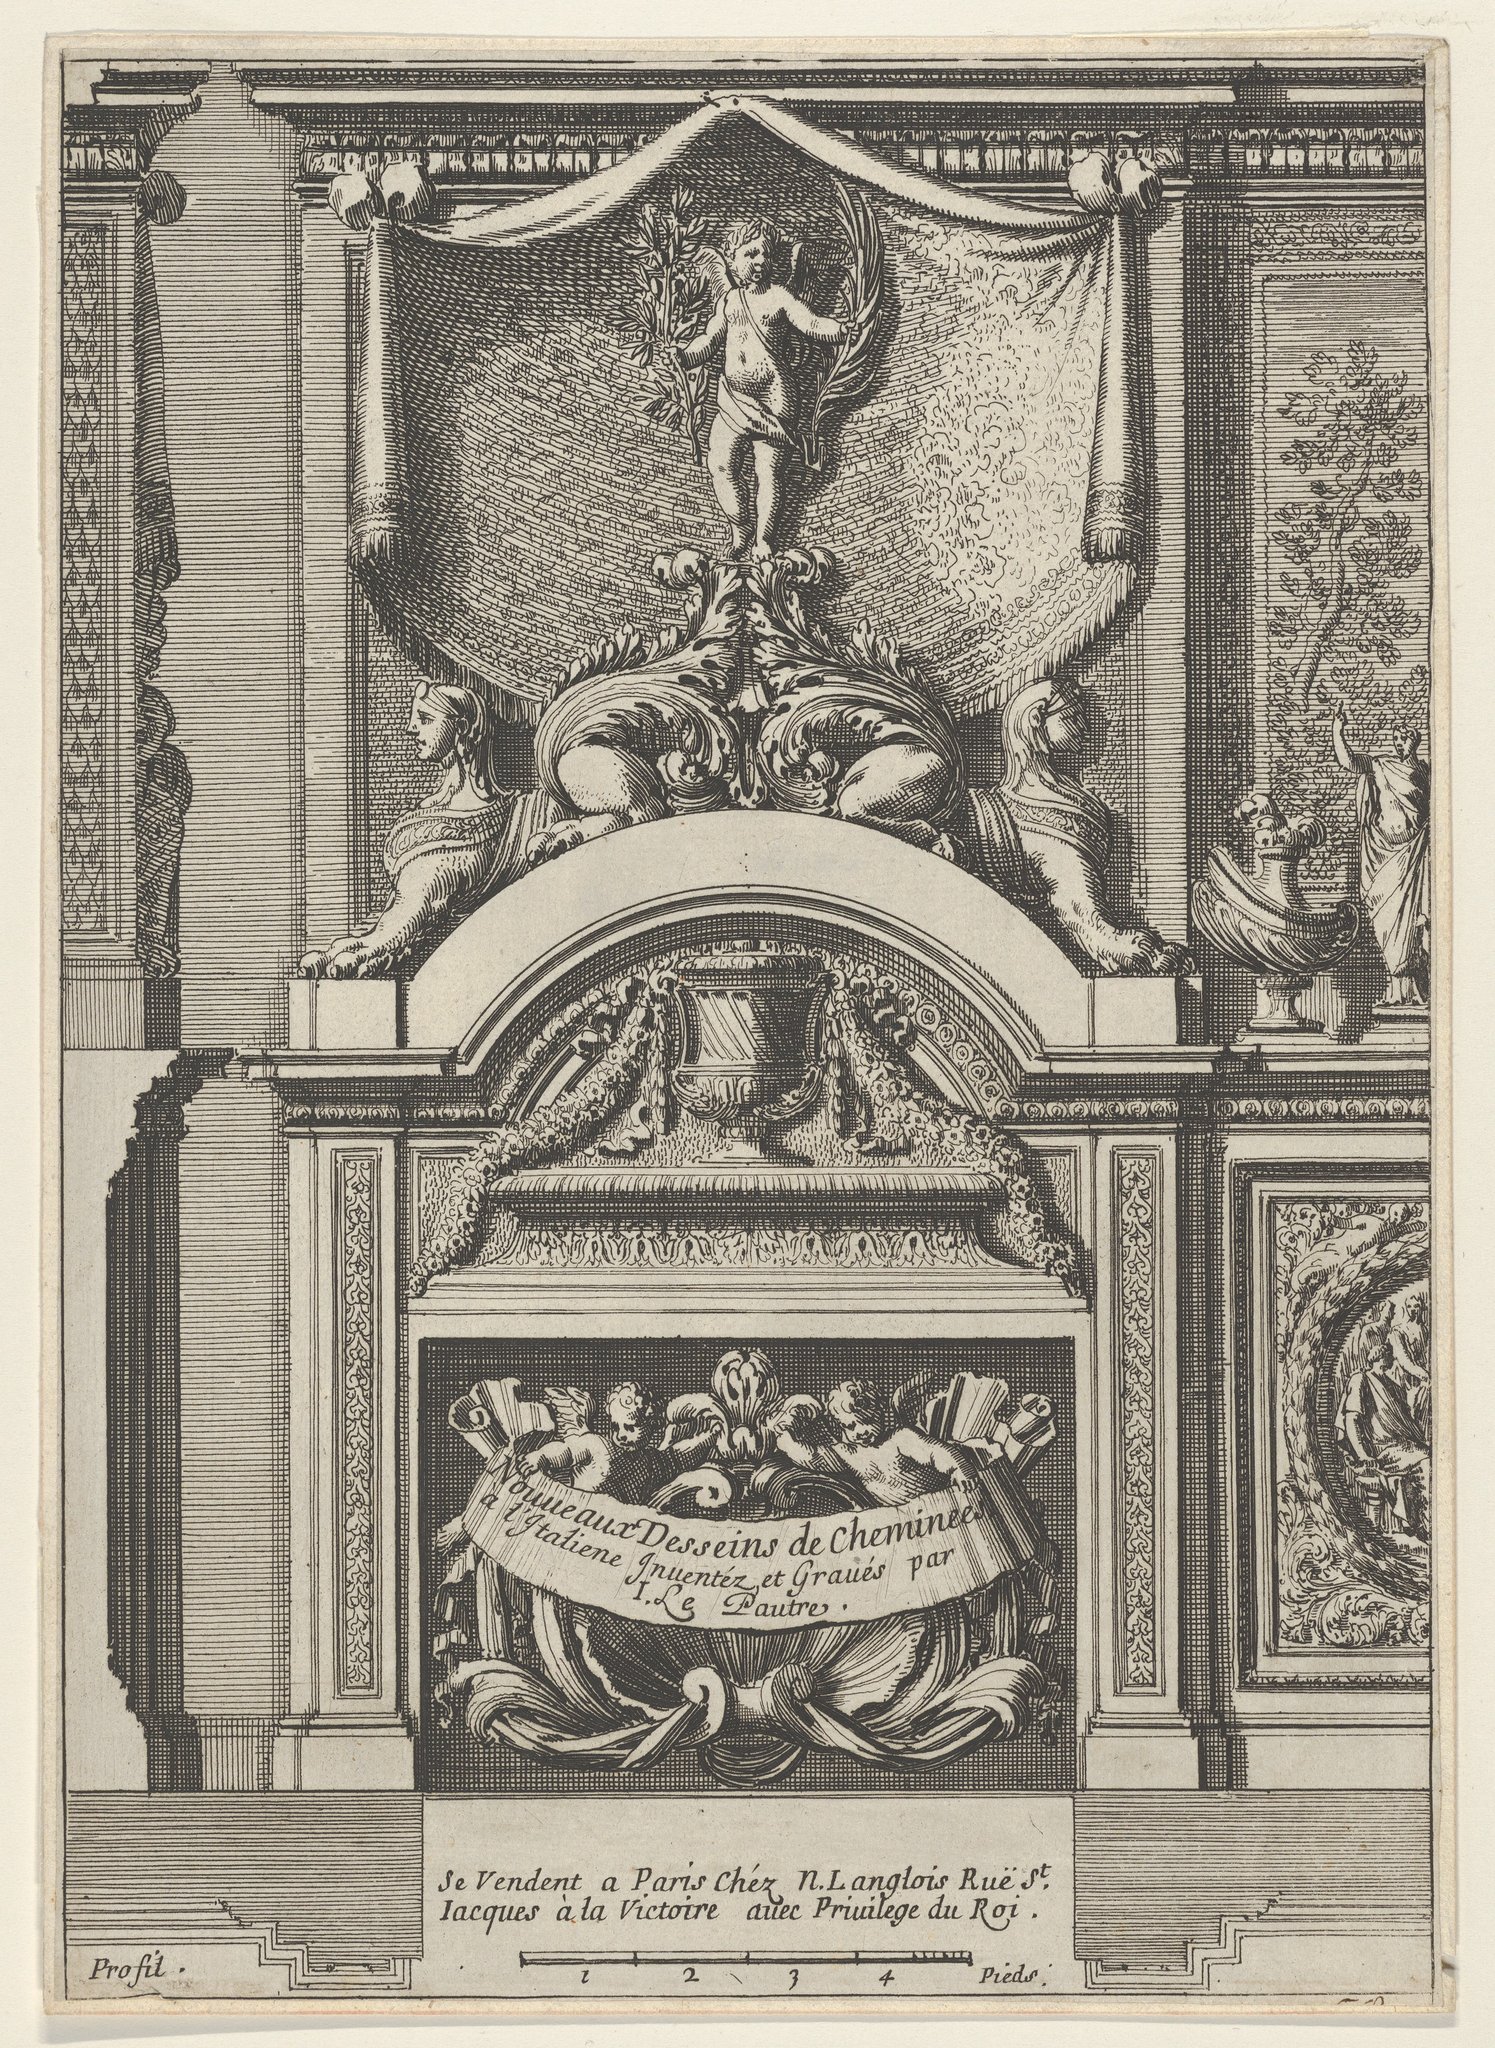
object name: print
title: Design for a Fireplace Surmounted by Sphynxes and Cupid, title page from "Nouveaux dessins de cheminées à l'italienne"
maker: jean le pautre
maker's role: artist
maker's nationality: french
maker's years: 1618-1682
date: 1640-1682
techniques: etching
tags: fireplaces,cupid